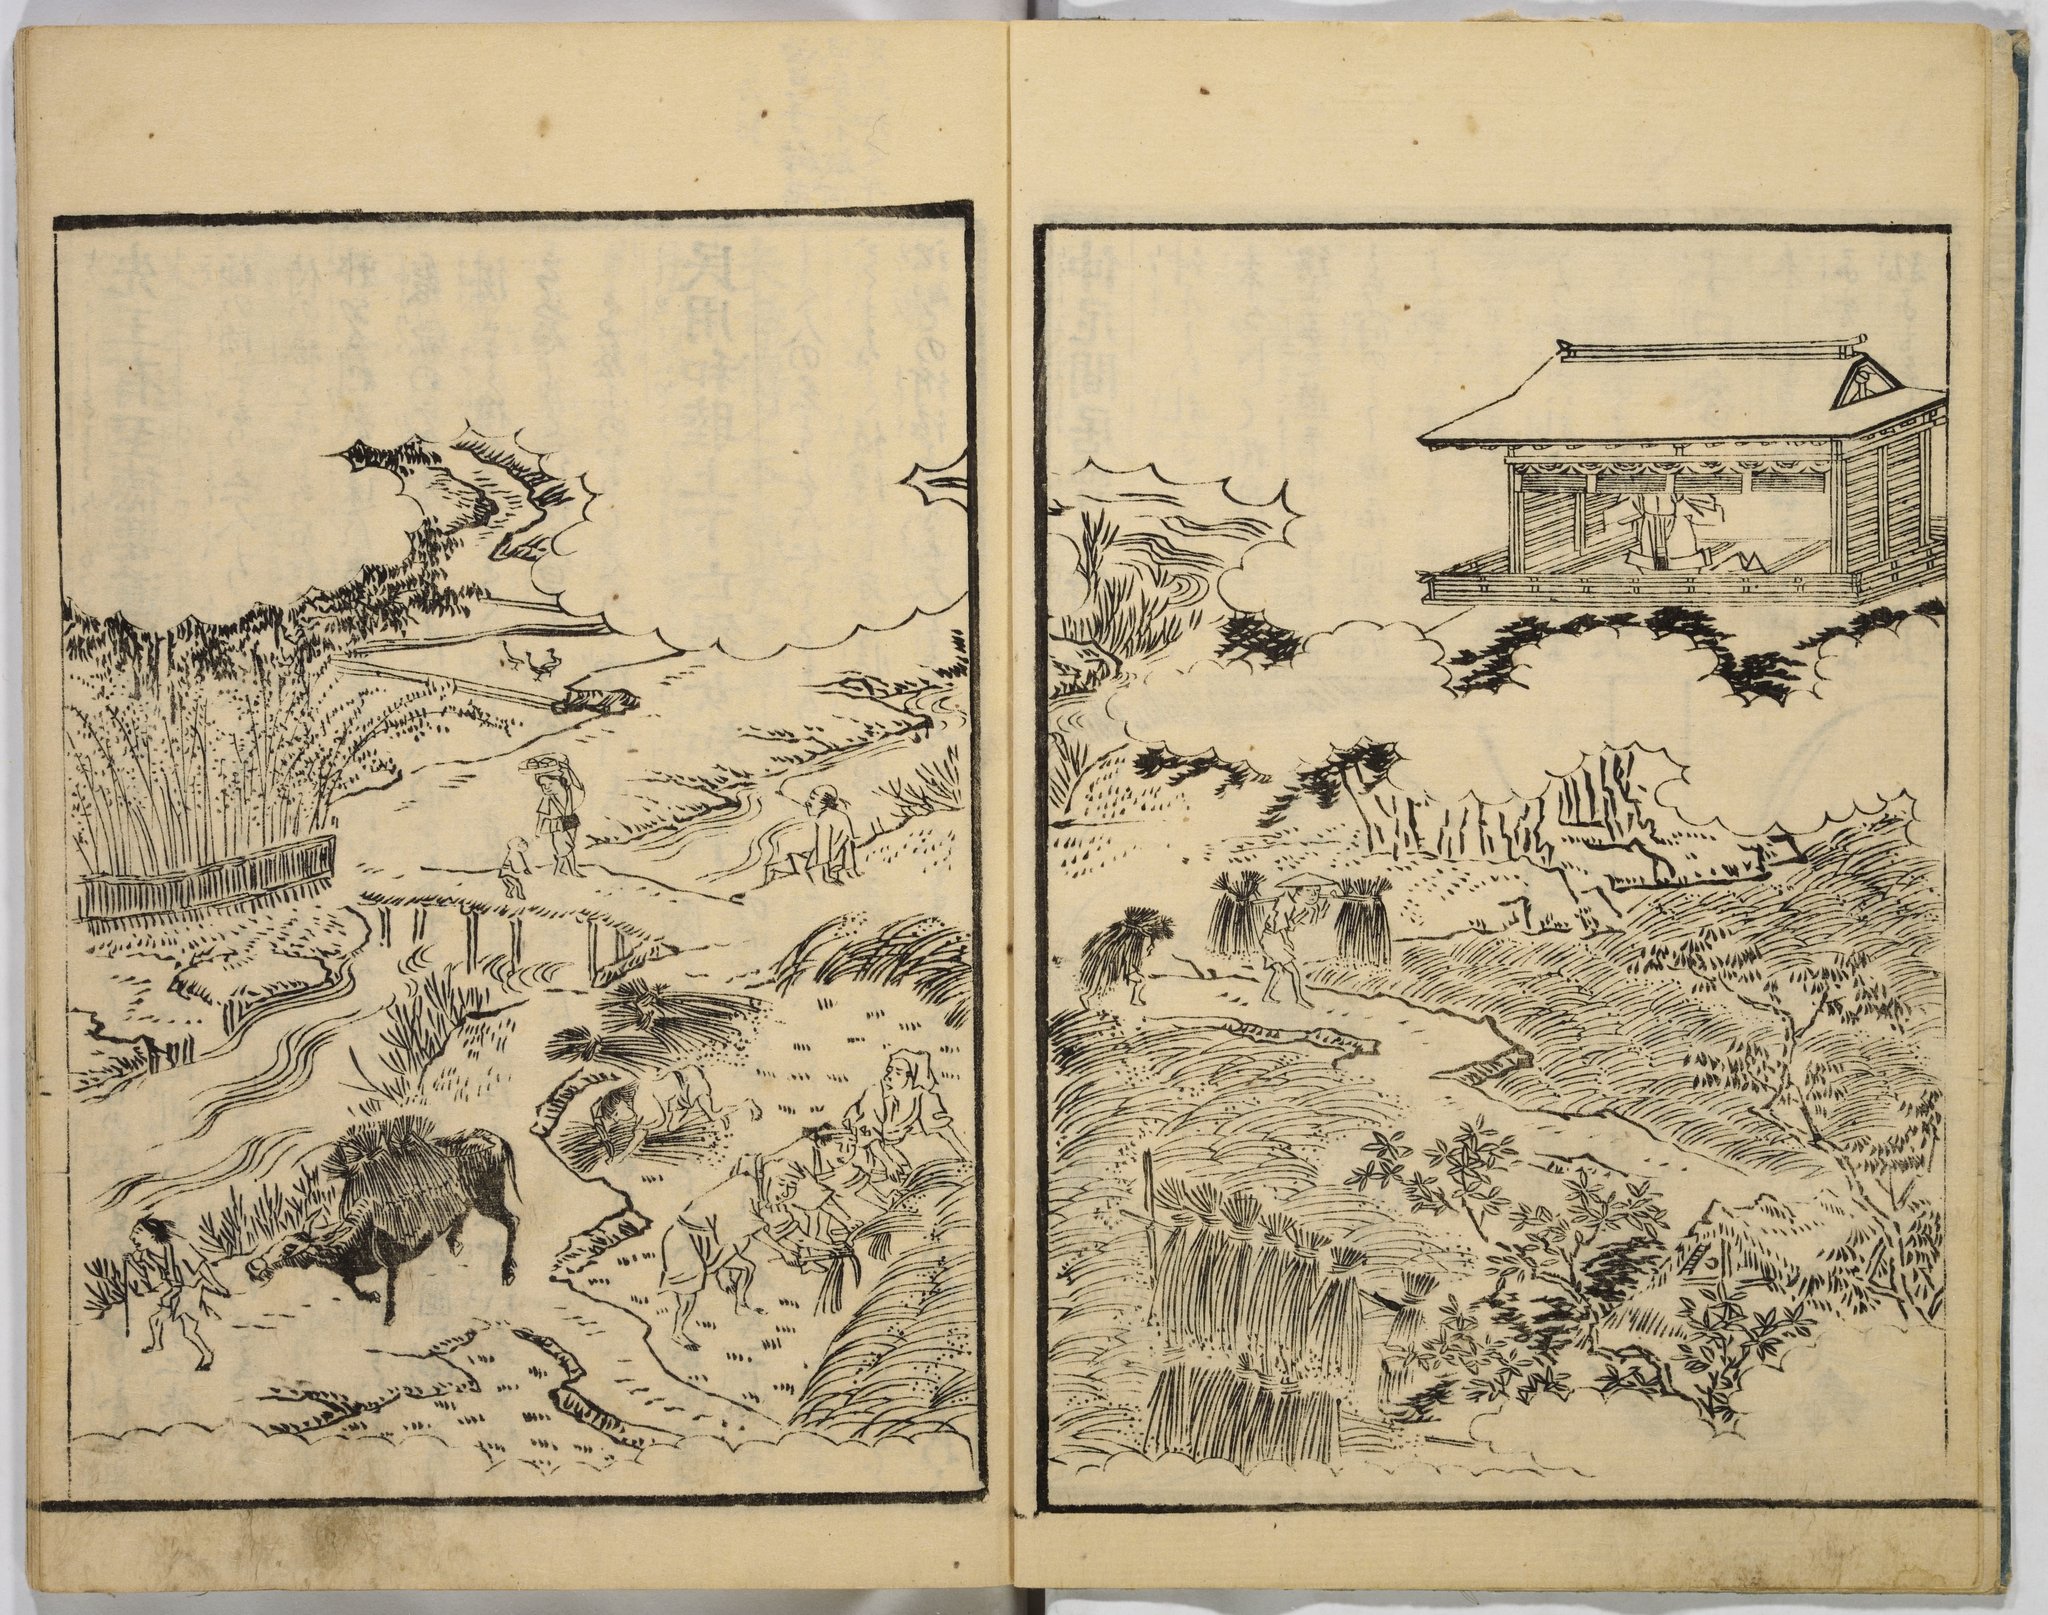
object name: illustrated book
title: Illustrated Book of Filial Piety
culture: japanese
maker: keisai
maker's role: artist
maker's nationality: japanese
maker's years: 1890-1900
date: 1813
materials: ink, paper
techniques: woodblock print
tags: human figures,houses,landscapes,working